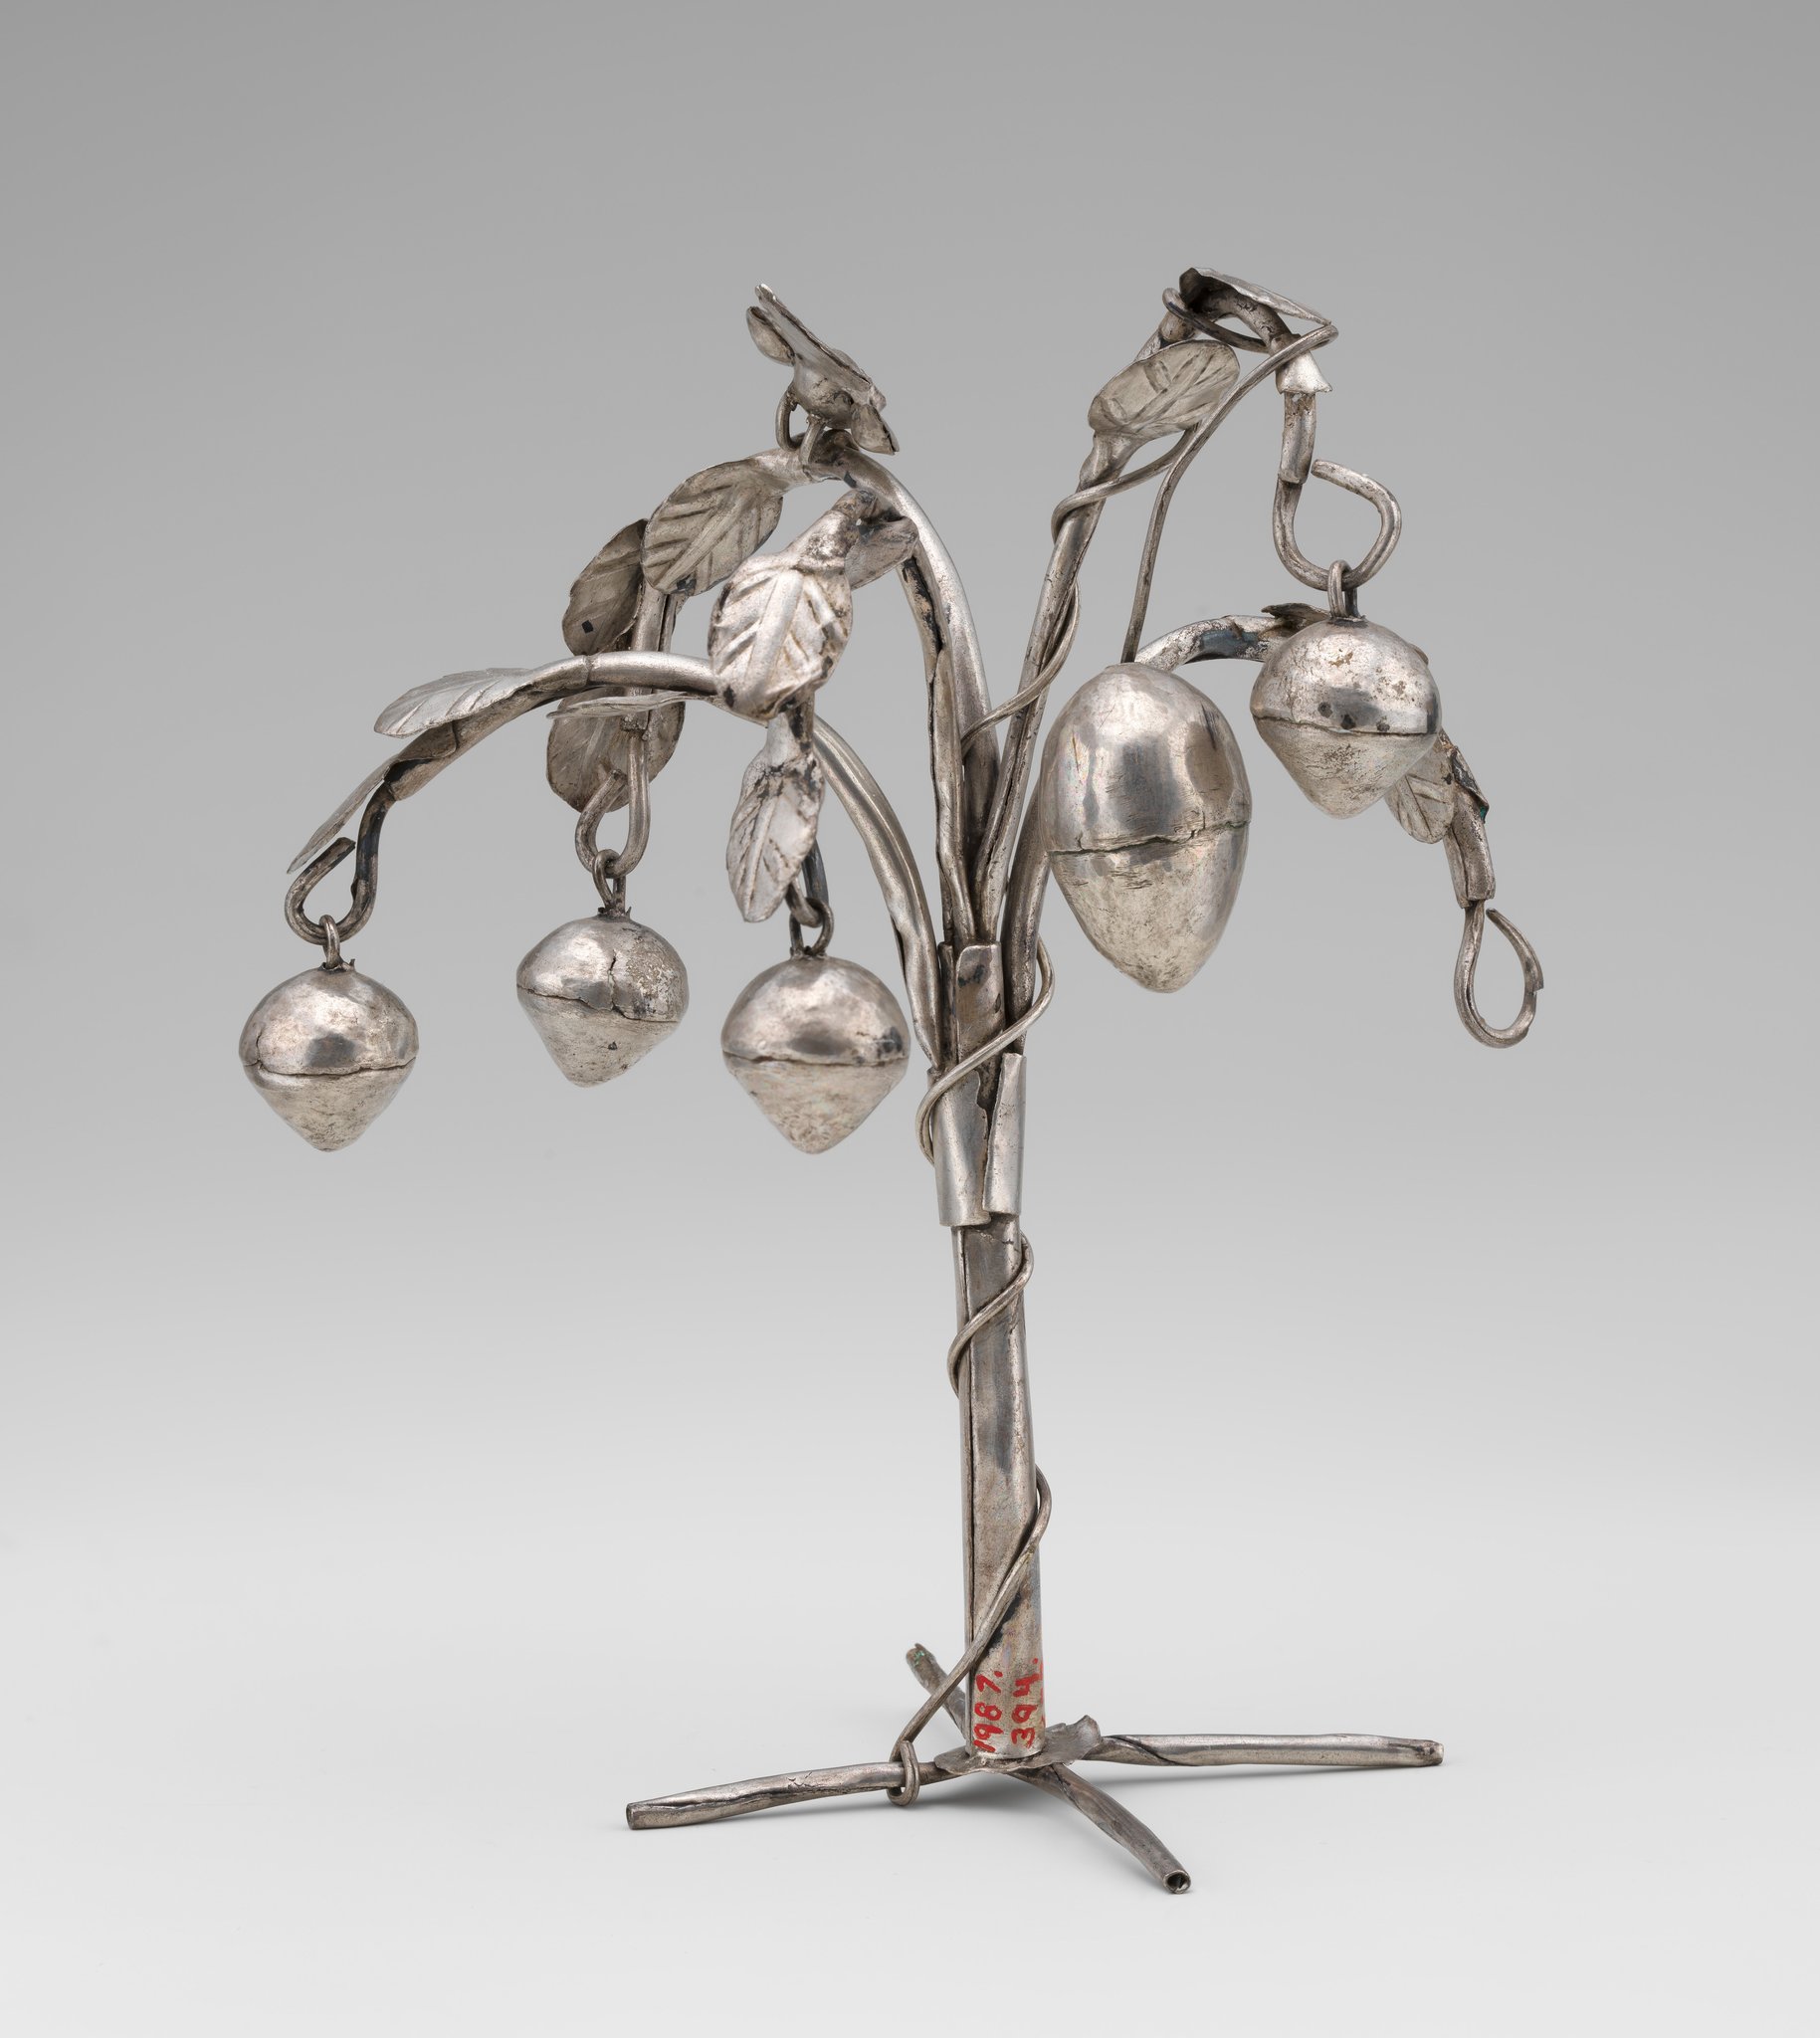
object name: tree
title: Miniature tree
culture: chancay or chimú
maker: chimú or chancay artist(s)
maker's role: artist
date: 1300-1470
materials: silver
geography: peru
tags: trees